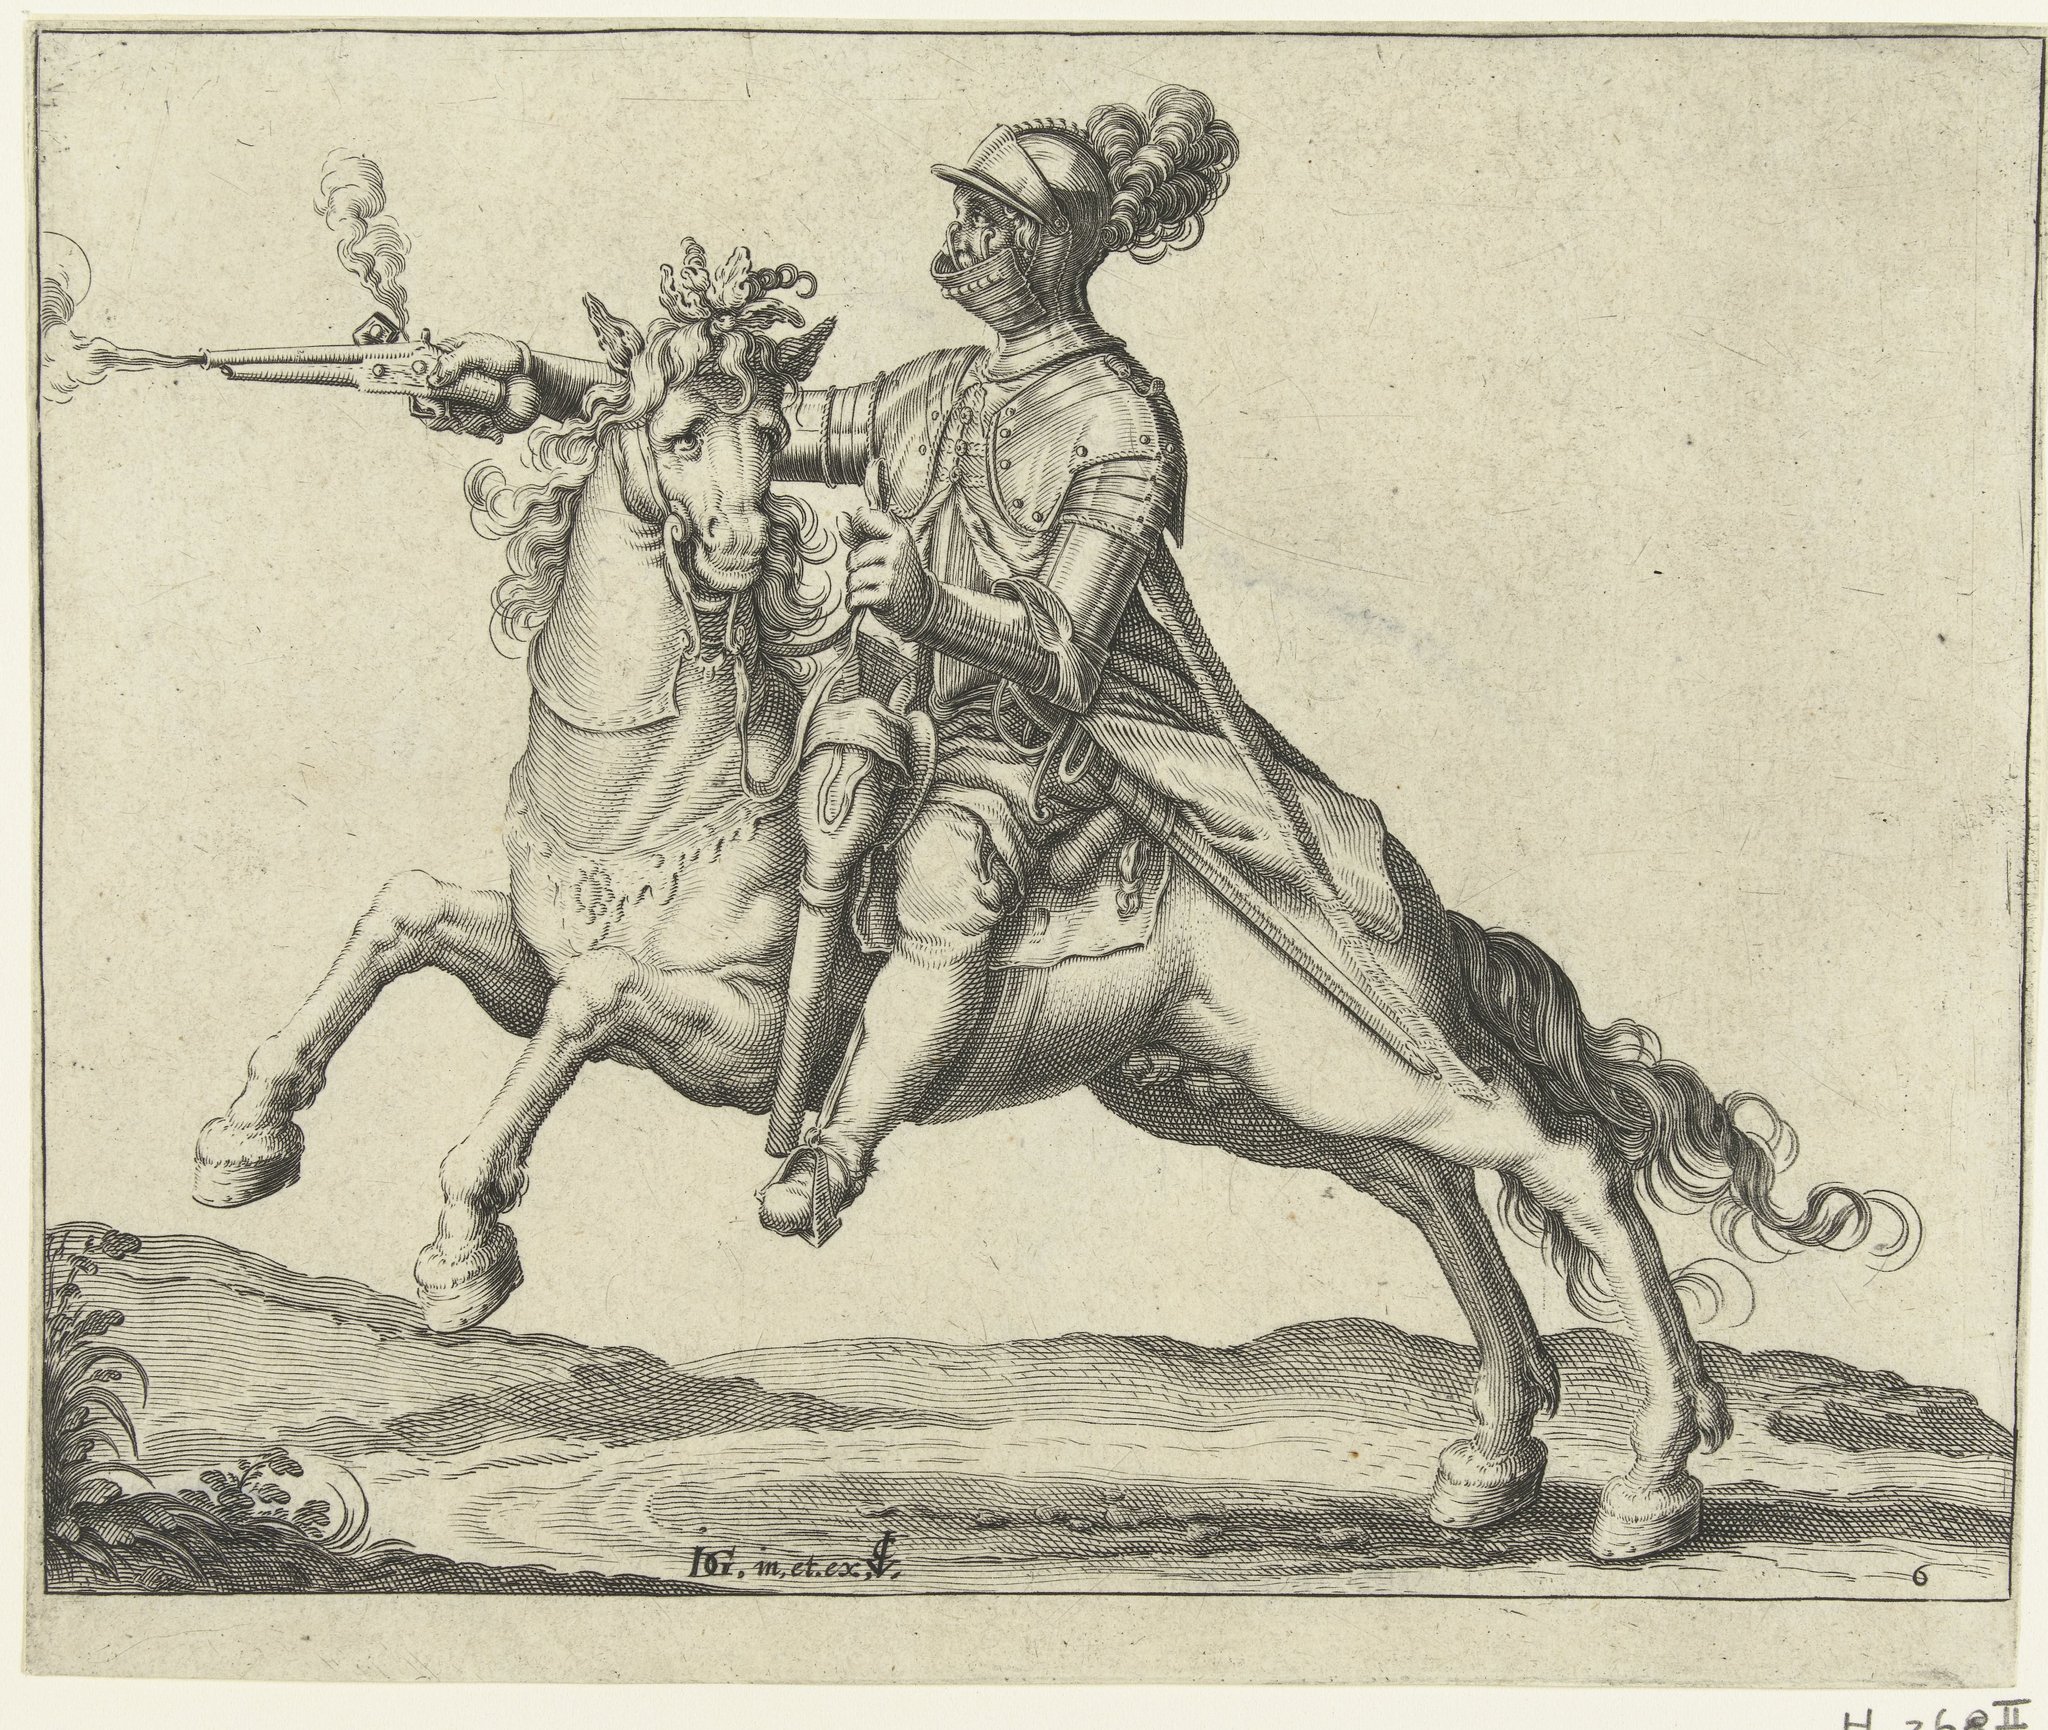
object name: print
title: Ruiter die een schot lost met een pistool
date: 1599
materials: paper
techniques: engraving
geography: amsterdam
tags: warfare; military affairs (+ cavalry, horsemen), firearms: rifle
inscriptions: collector's mark: Lugt 2228a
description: Een geharnaste man te paard, naar links rijdend, een schot vurend met het pistool in zijn rechterhand. Deze prent is onderdeel van een serie van 22 genummerde prenten: een titelprent, 20 prenten waarop één of enkele verschillende typen (meest geharnaste) ruiters zijn weergegeven, en een prent met een ruitergevecht.